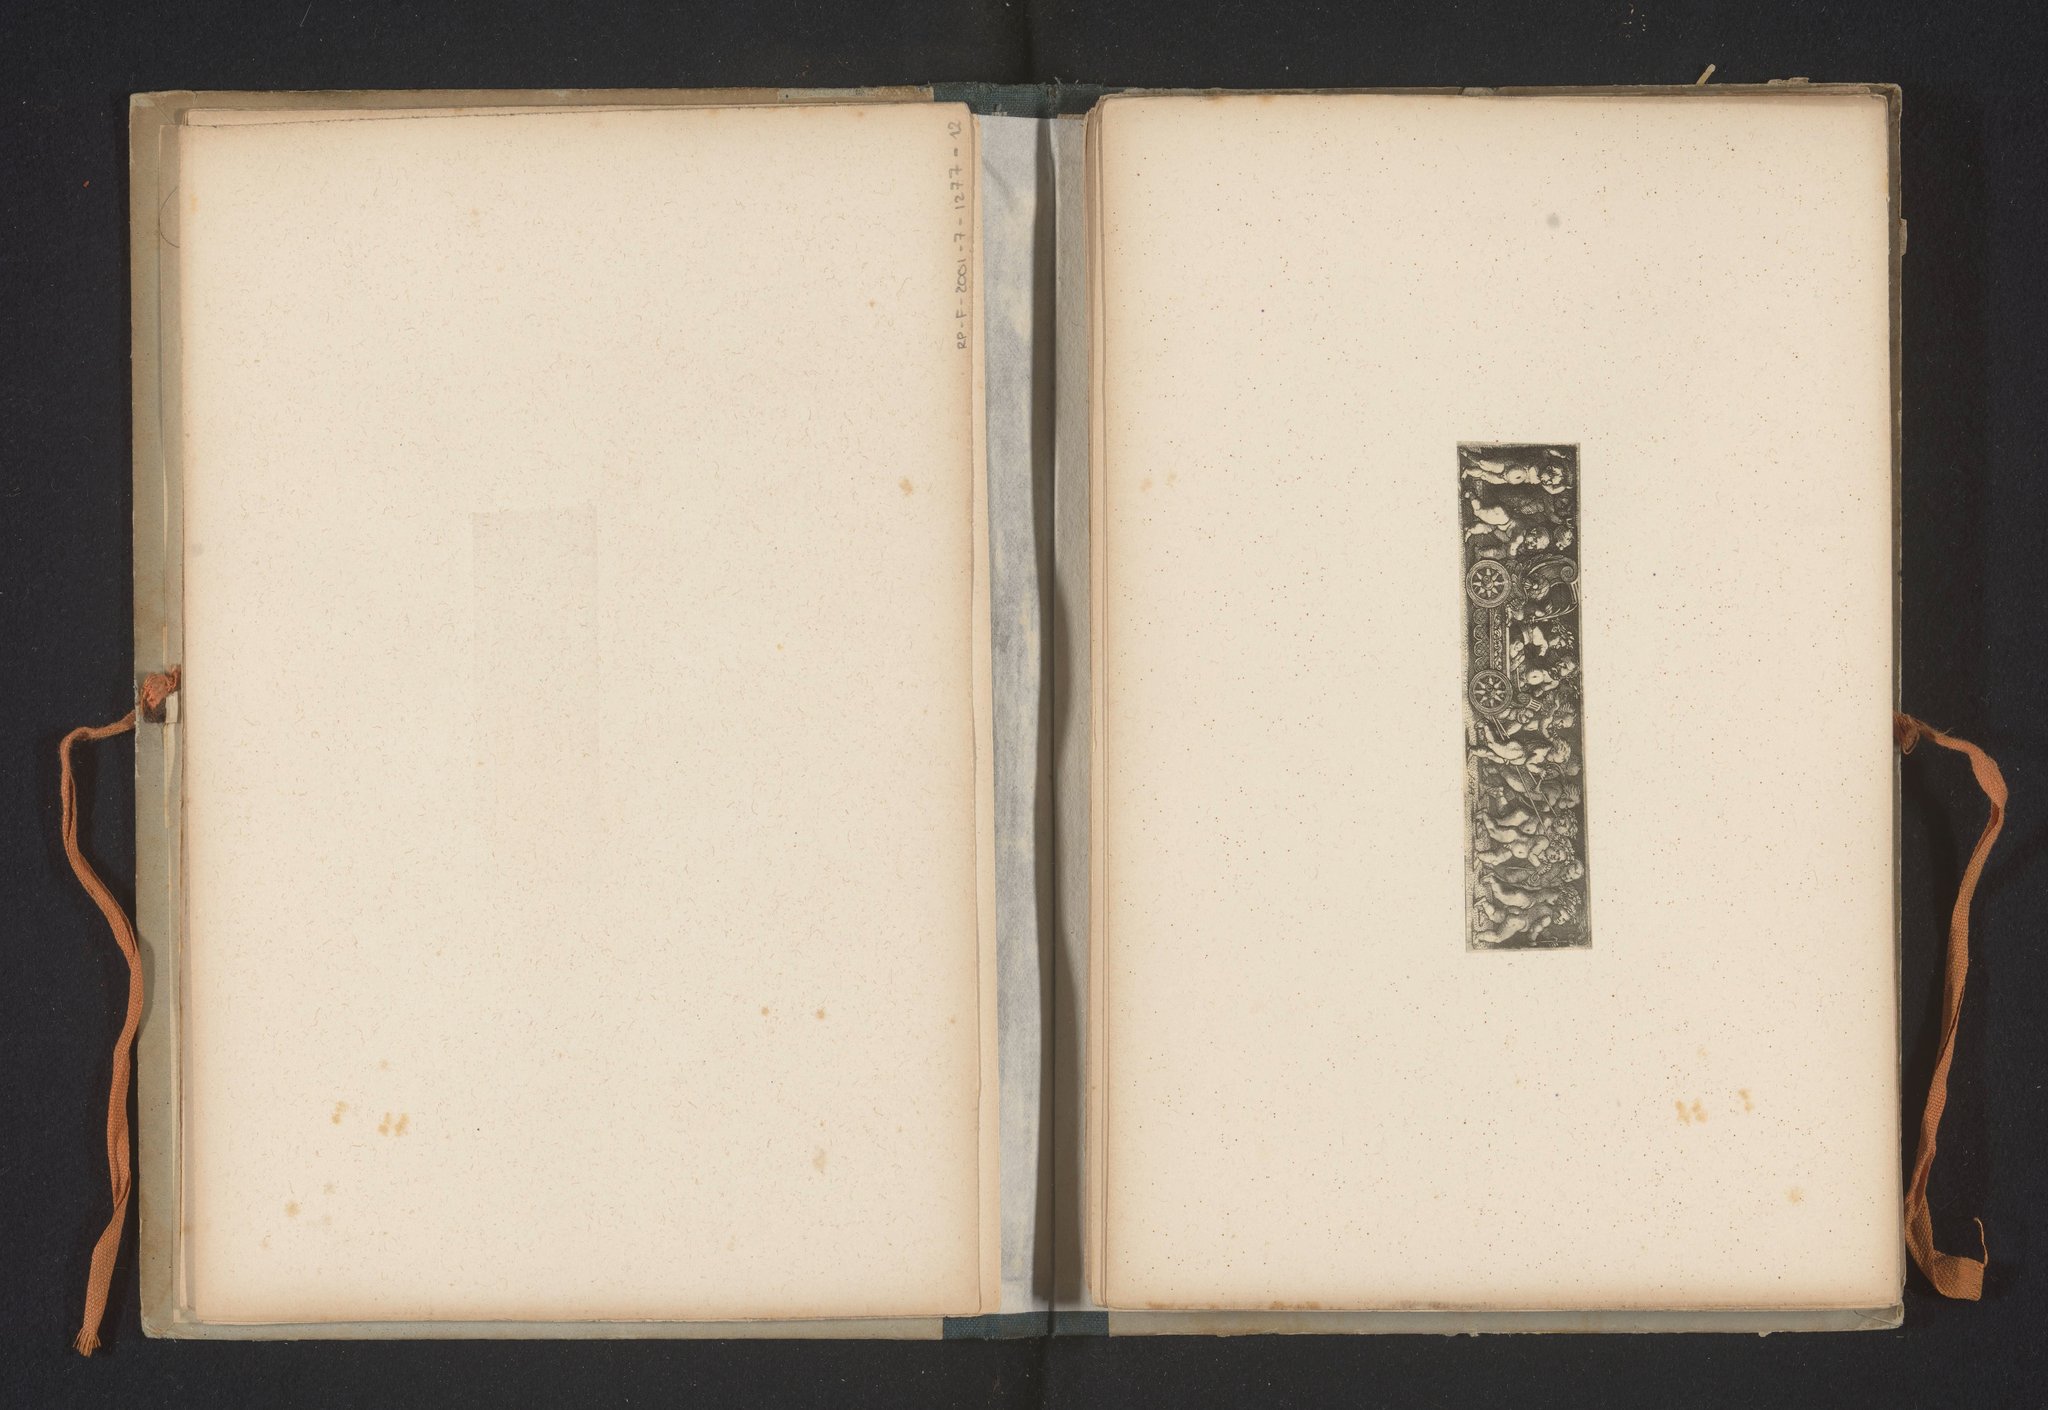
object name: photomechanical print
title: Reproductie van een prent van cupido's rond een kar, door Hans Sebald Beham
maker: hans sebald beham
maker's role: designer, draughtsman, print maker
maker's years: 1500-1550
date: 1866-1871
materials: paper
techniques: woodburytype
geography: brussels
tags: hand-cart, cupids: 'amores', 'amoretti', 'putti'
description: Deze prent maakt deel uit van een omslag met 57 prenten op 54 bladen.